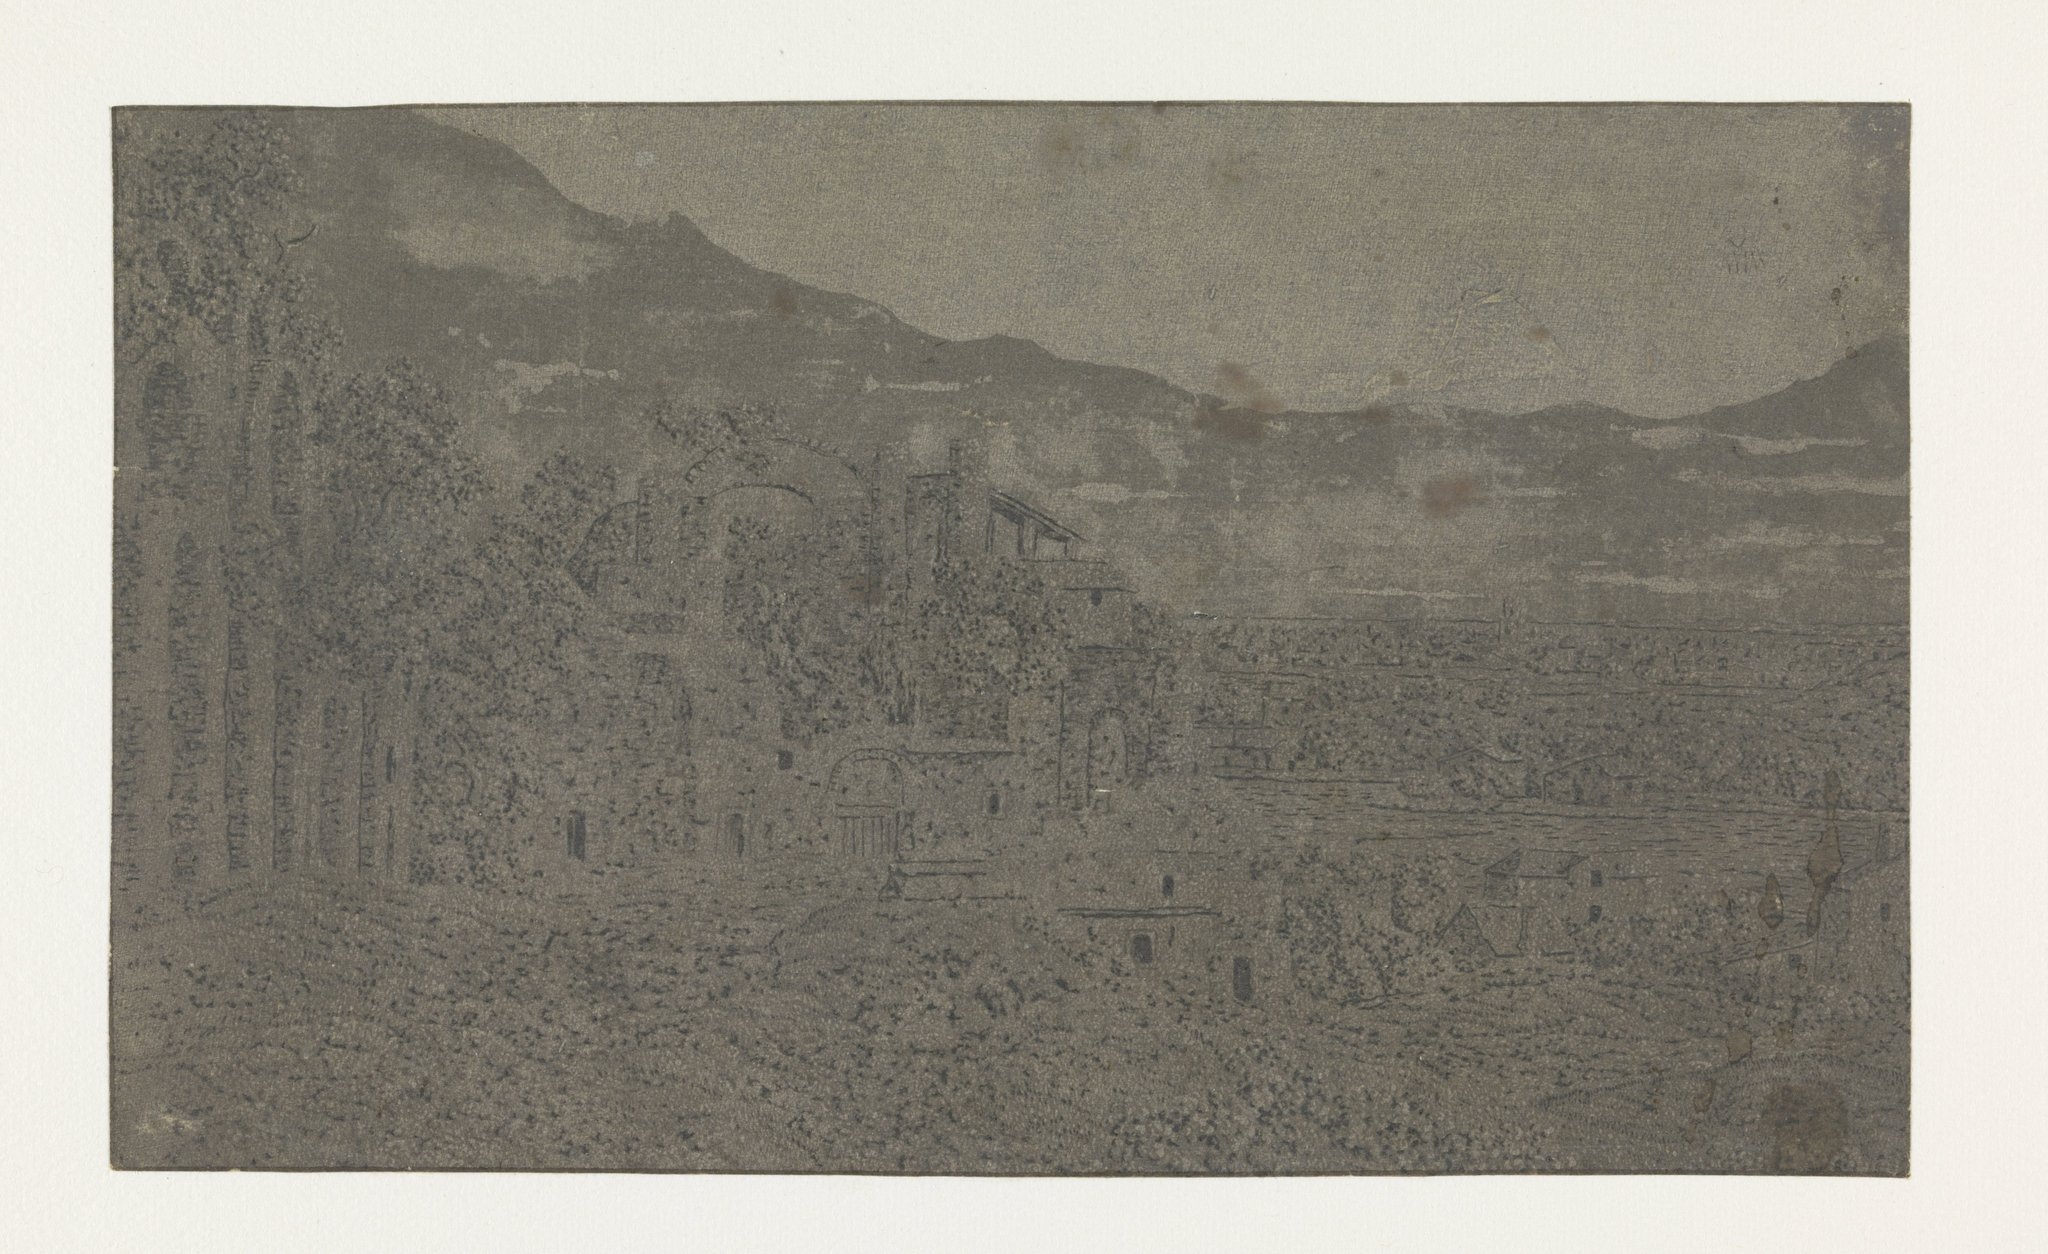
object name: print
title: Roman Ruins, a City in the Distance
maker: hercules segers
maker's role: draughtsman, painter, print maker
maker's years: 1589-1640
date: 1615-1630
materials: paper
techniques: etching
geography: amsterdam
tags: ruin of a building ~ architecture, landscape with ruins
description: Segers etched two plates for this print. One was a tone plate with fine crosshatching, which he printed in a greyish blue. The other had the depiction of the ruins and the city, which he printed in black over the tone.